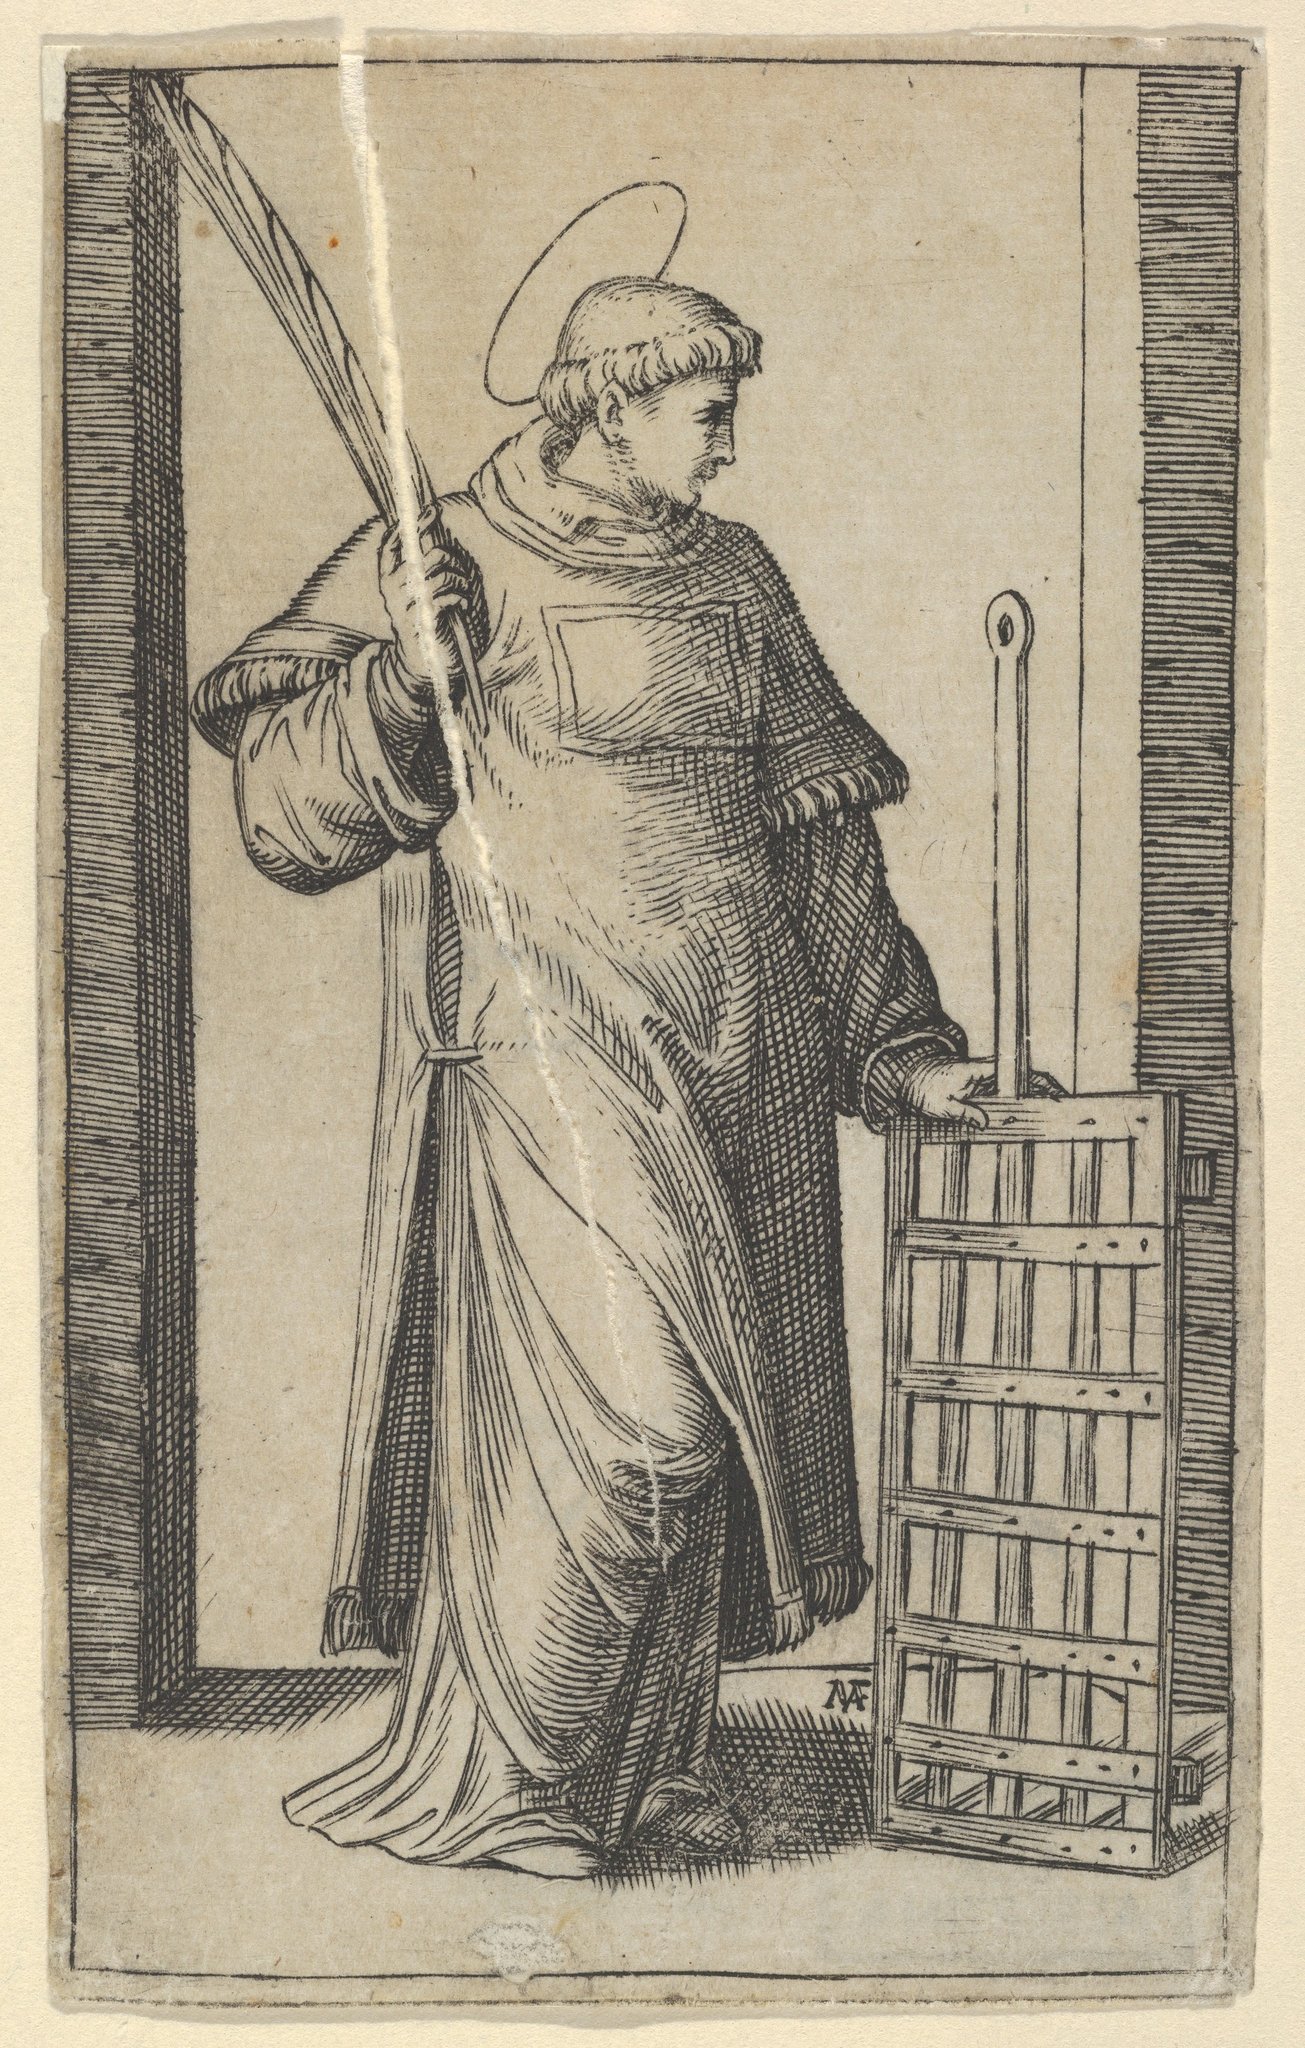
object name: print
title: Saint Lawrence, left hand resting on a grill, from "Piccoli Santi" (Small Saints)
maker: marcantonio raimondi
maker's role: artist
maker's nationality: italian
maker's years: 1475-1534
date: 1500-1527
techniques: engraving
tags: saint lawrence